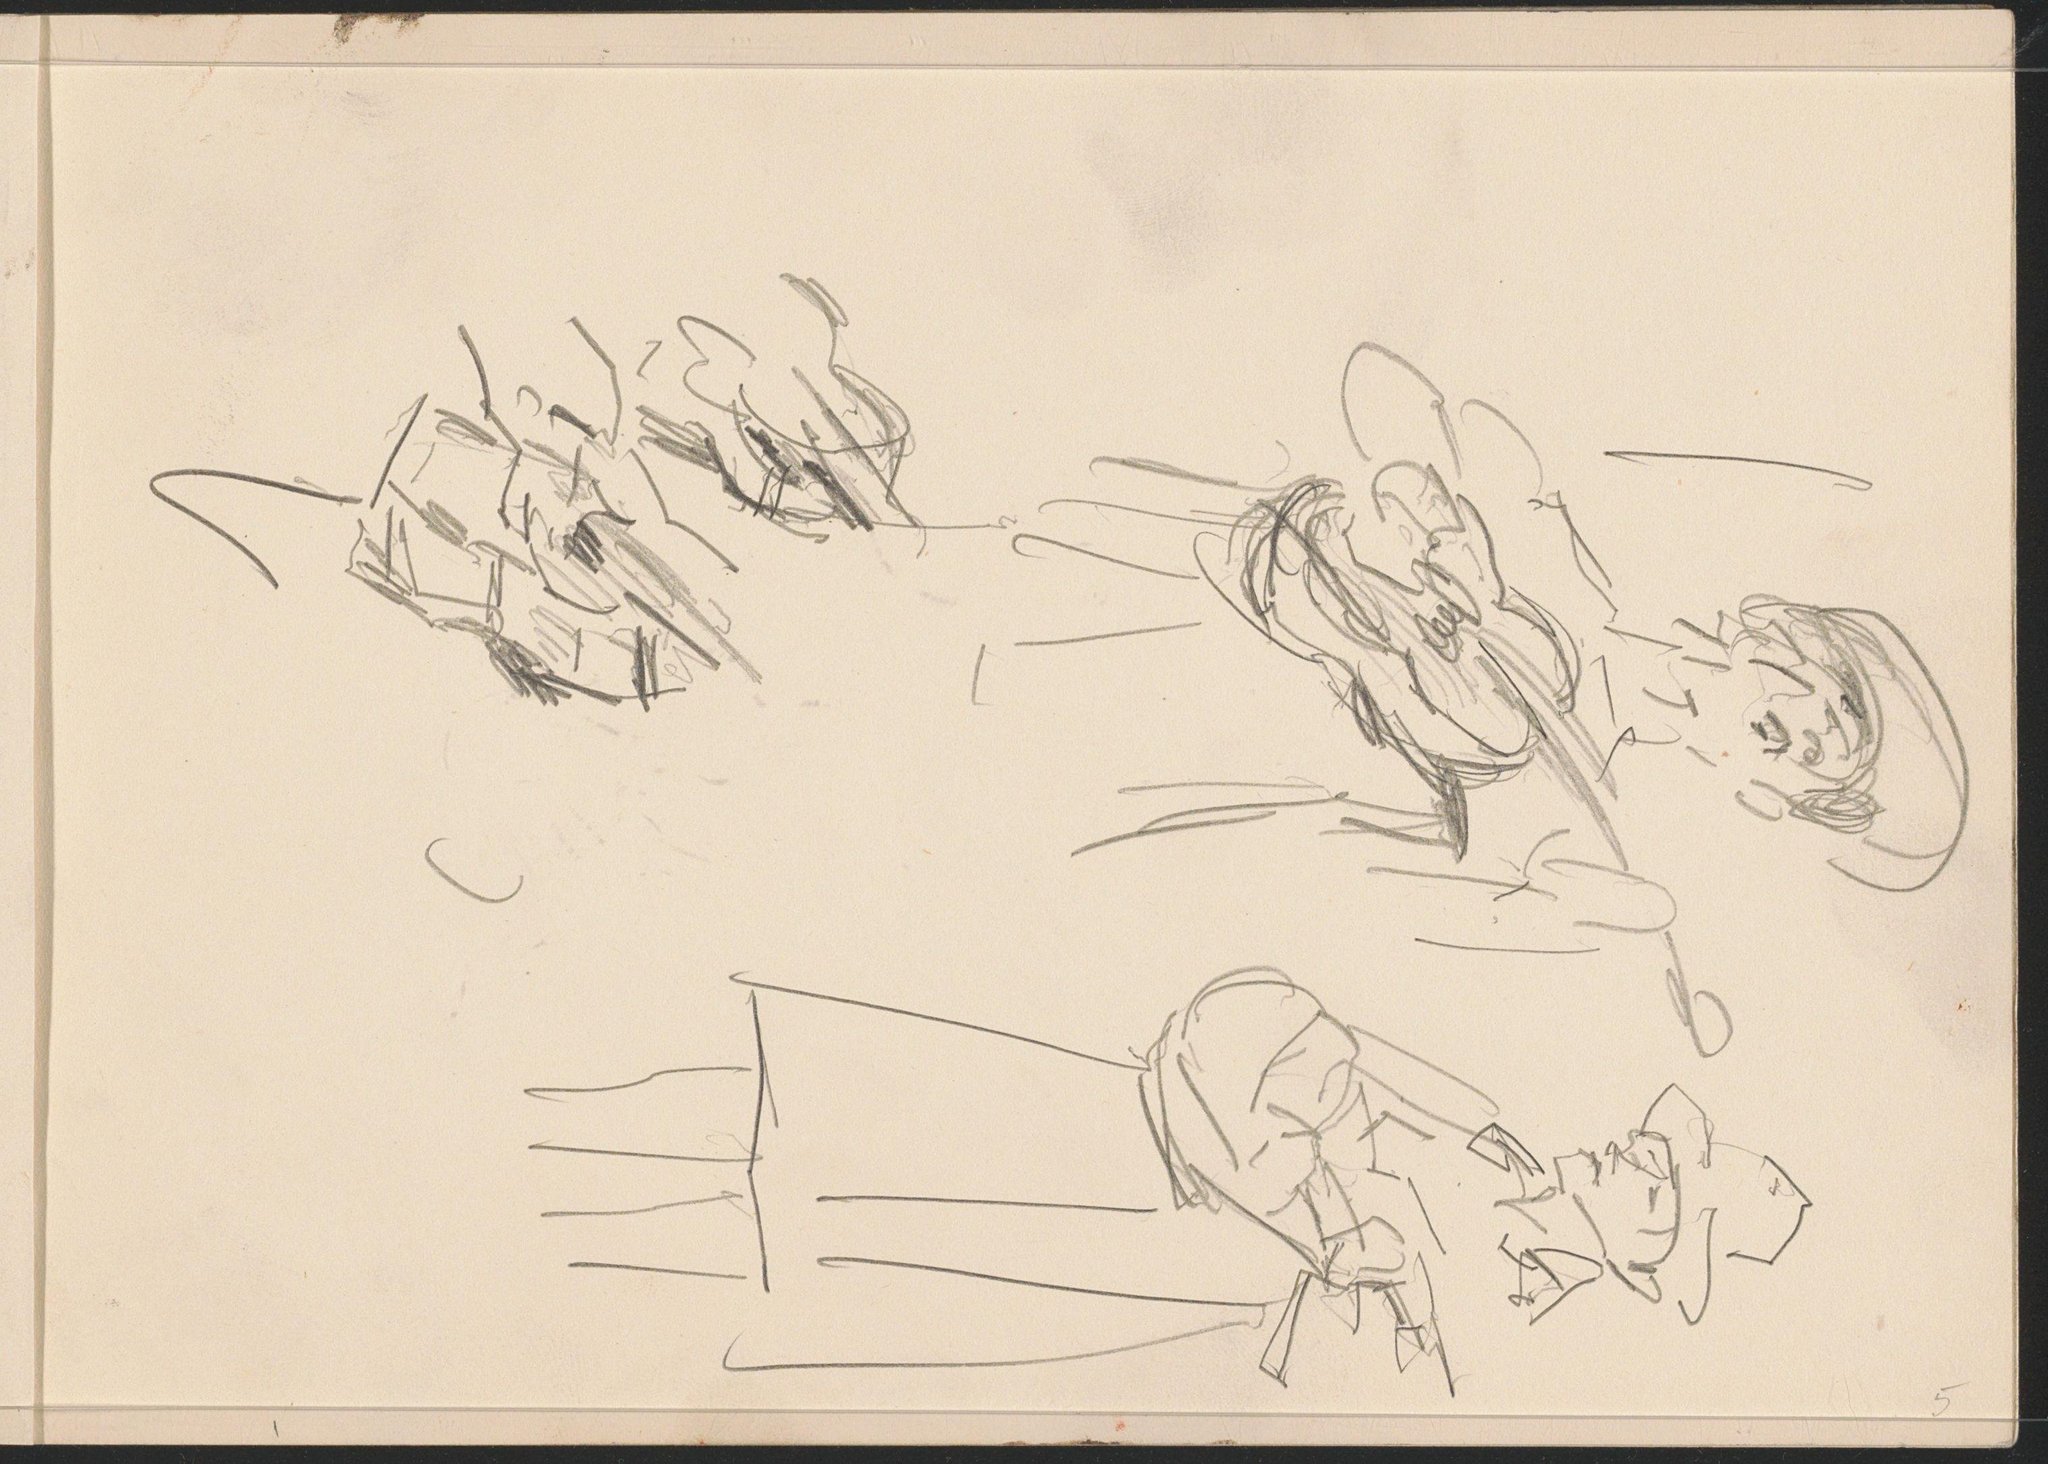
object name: sketchbook leaf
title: Studieblad met gitaarspelers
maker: isaac israels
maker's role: draughtsman, painter, print maker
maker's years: 1865-1934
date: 1930-1934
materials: paper, pencil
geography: the hague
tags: cithern, mandolin, guitar, balalaika (+ artist at work)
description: De mannen spelen gitaar of een aanverwant snaarinstrument. Ze dragen een hoed. Blad 5 recto uit schetsboek I met 26 bladen.